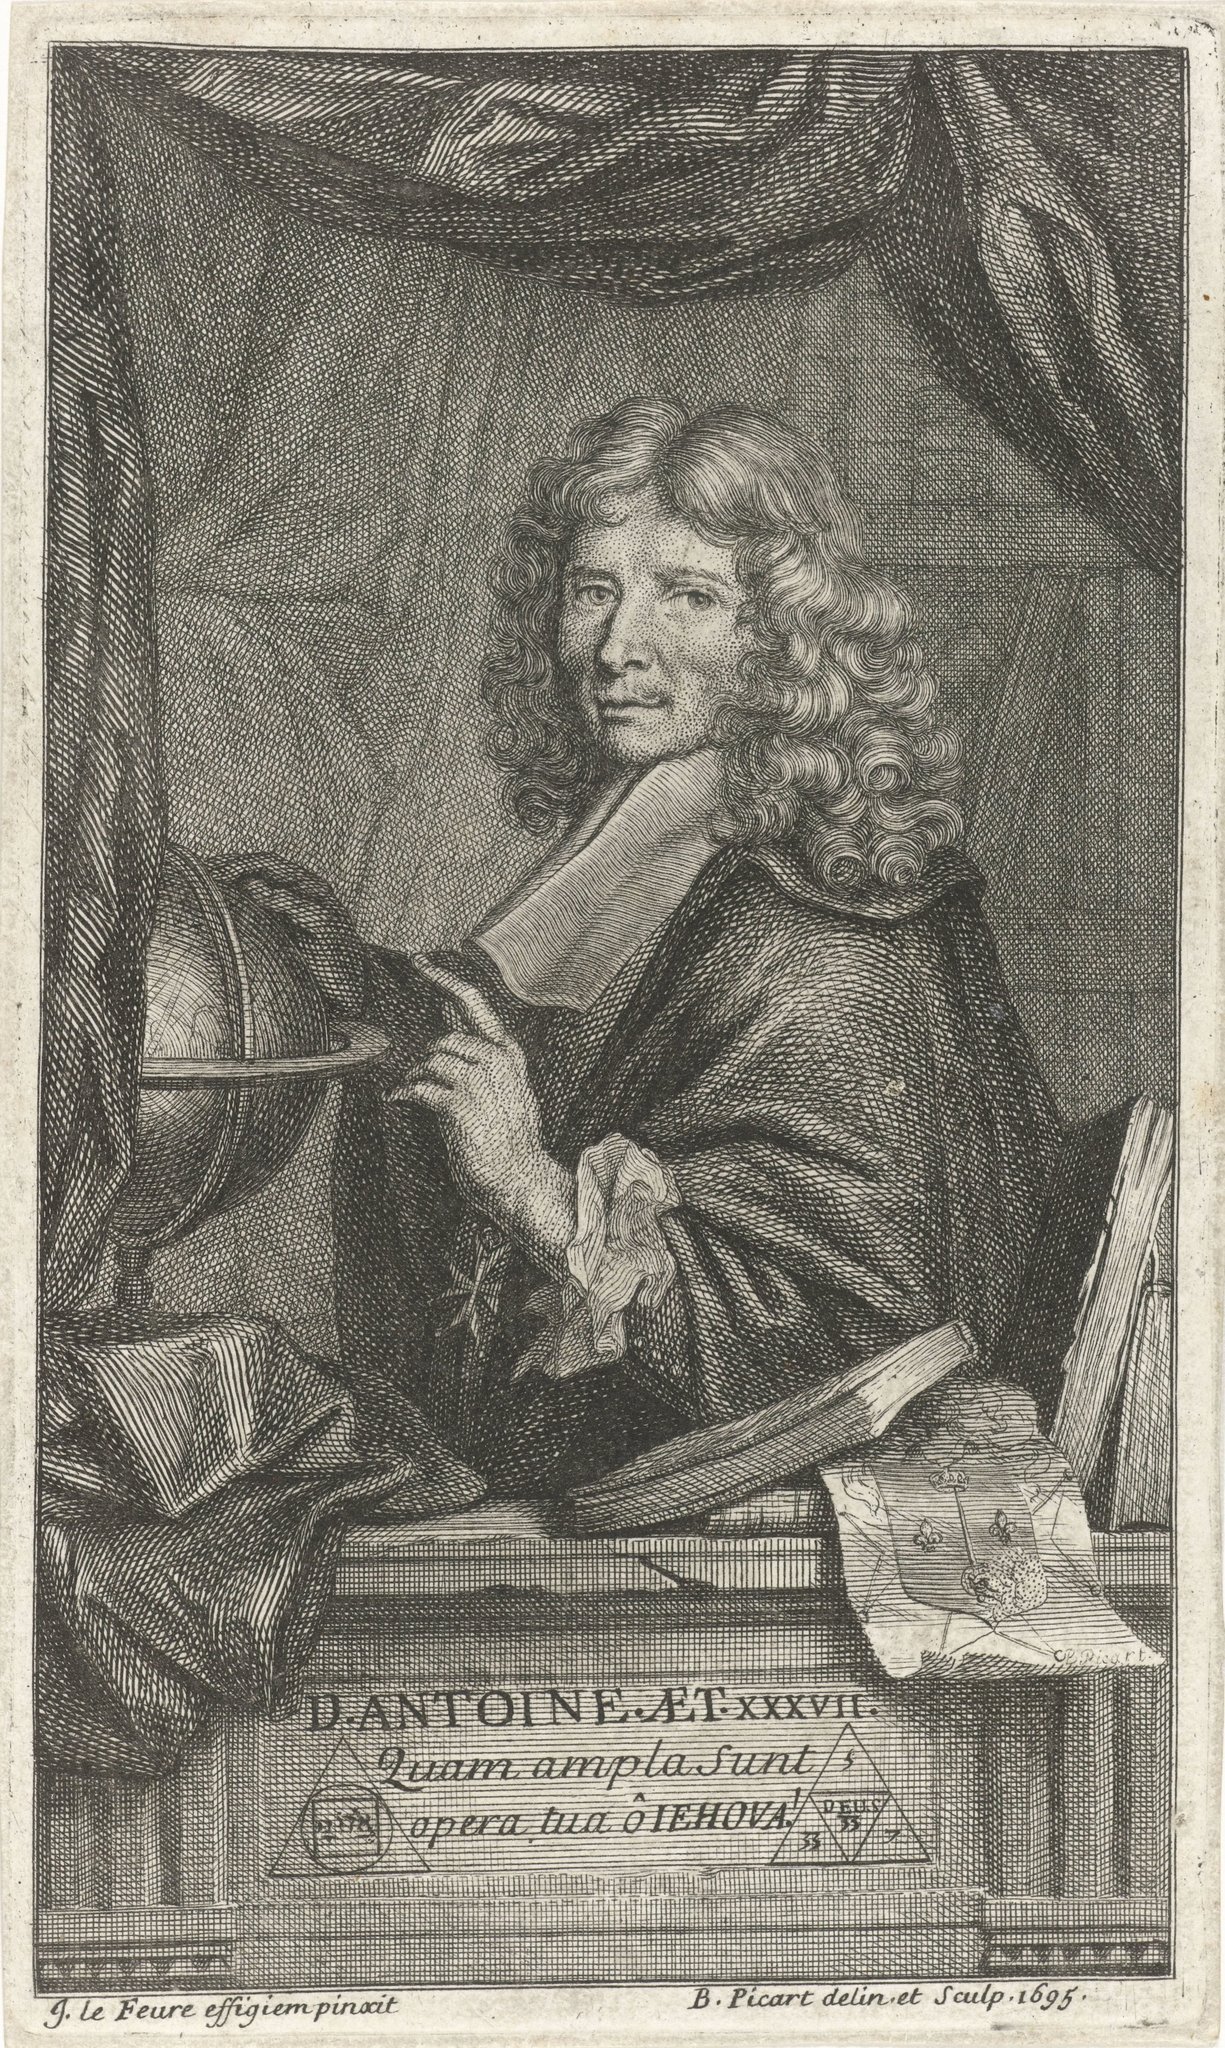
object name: print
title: Portret van de heer Antoine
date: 1695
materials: paper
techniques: engraving, etching, letterpress printing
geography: paris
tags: study; 'studiolo'; library, knighthood order of the holy spirit, globe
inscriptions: collector's mark: Lugt 2228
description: Portret van de heer Antoine, op 37-jarige leeftijd. Hij zit in zijn studeervertrek en bekijkt een globe. Hij draagt een lint met de Orde van de Heilige Geest. Op een vel papier zijn wapenschild.